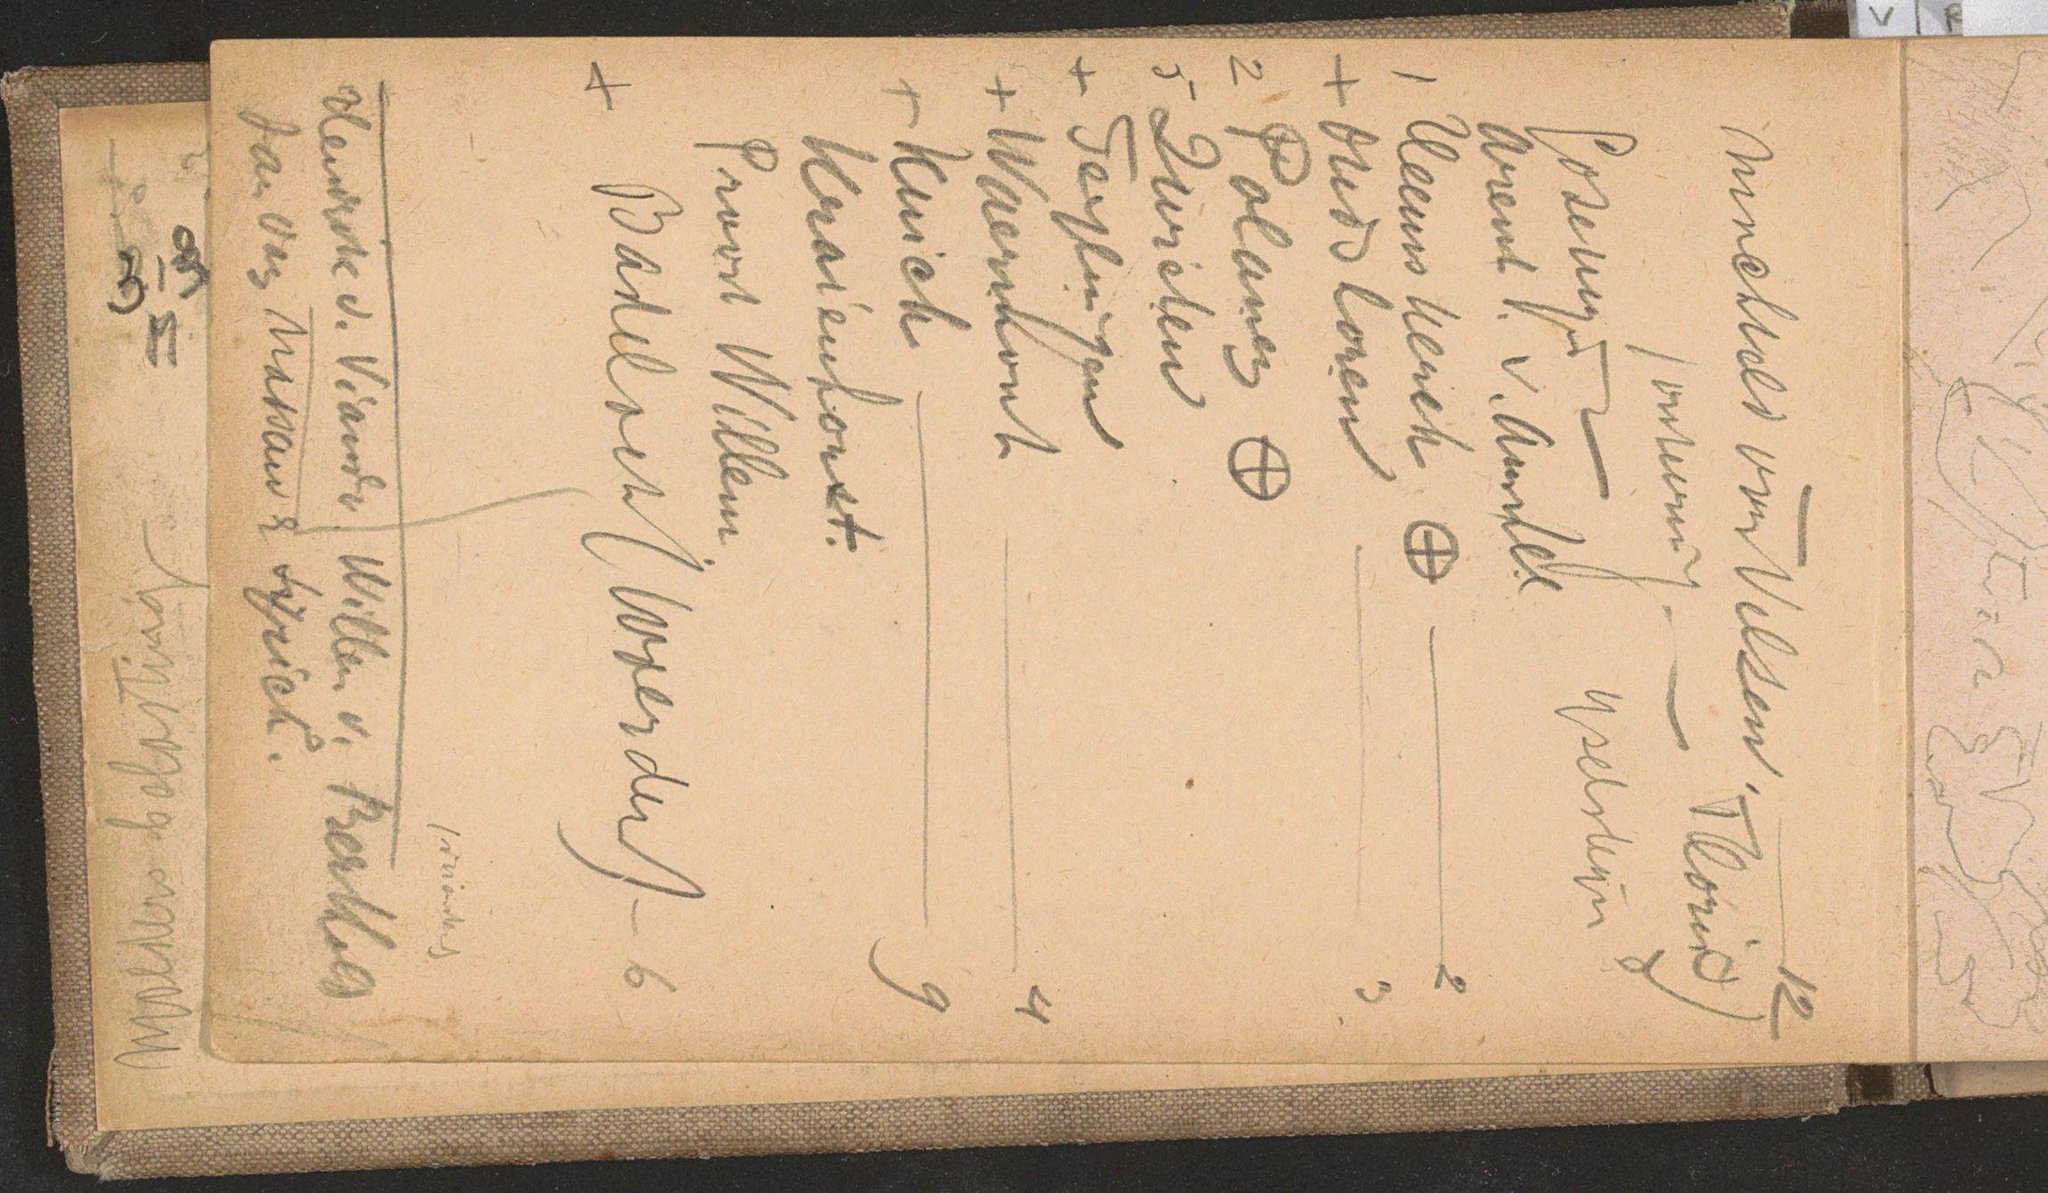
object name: sketchbook leaf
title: Notities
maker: antoon derkinderen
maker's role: draughtsman, painter, print maker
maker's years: 1859-1925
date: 1892-1901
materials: paper, pencil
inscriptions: annotation: ‘[...] van Velzen/ [...]/ arent v. Amstel/ Yselsteyn/ 1 Heemskerck + 2/ [...]’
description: Blad 1 verso uit een schetsboek met 51 bladen.